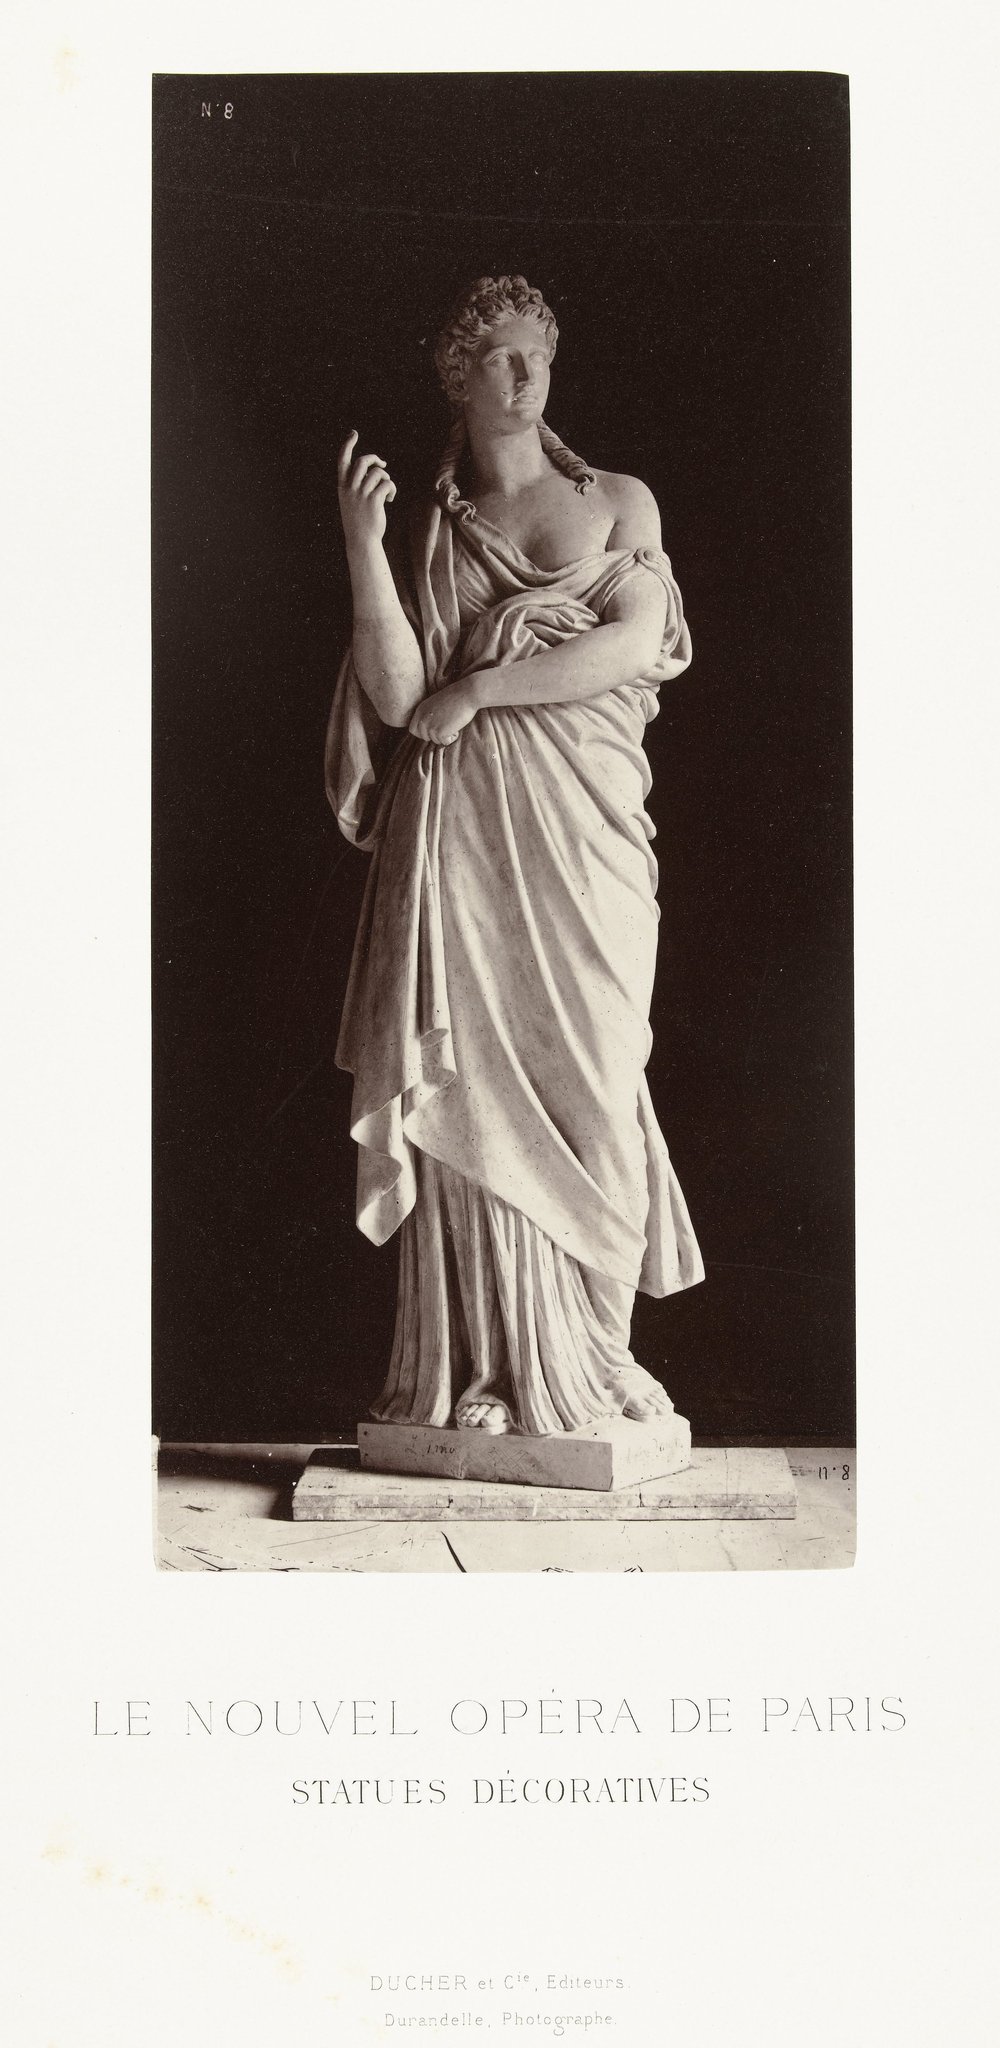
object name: photograph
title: Marmeren standbeeld van een vrouw met een toga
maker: louis-emile durandelle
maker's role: fotograaf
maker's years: 1839-1917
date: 1878-1881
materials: photographic support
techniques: gelatin silver print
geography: paris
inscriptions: number: ‘8’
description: Bij boek in Bibliotheek RMA, Zie Frizot, pp. 217-223, vgl G. Vicaire, Manuel de l'amateur de livres du XIXe siècle, vol. 3, column 870.